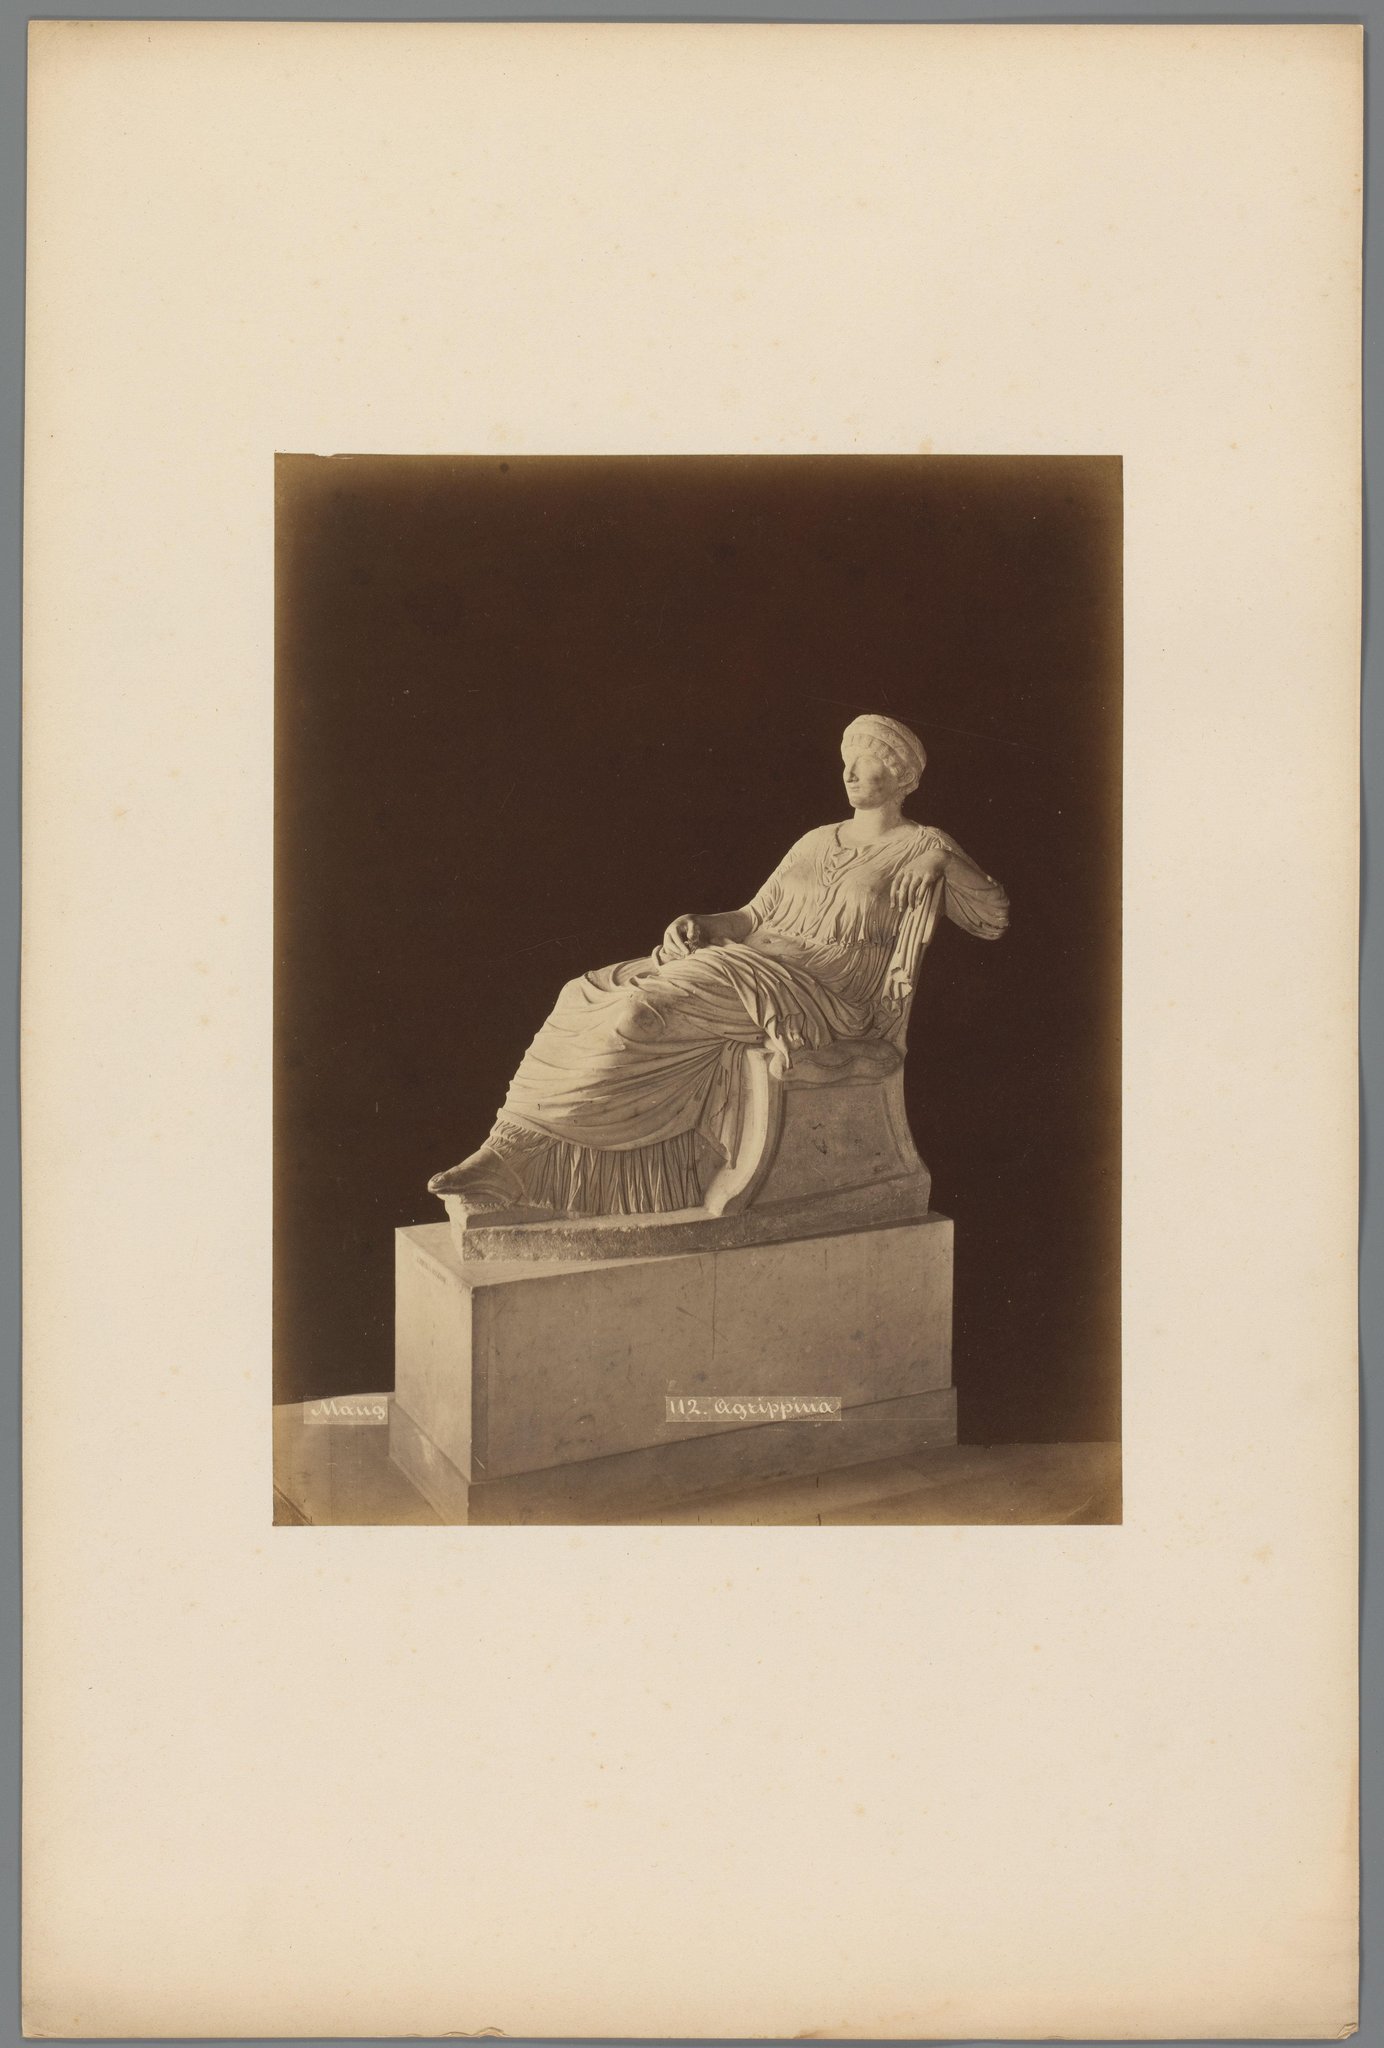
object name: photograph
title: Sculptuur van een zittende Agrippina de oudere in de Capitolijnse Musea te Rome, Italië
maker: michèle mang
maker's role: fotograaf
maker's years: 1840-1909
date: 1863-1887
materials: cardboard, paper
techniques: albumen print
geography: rome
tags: piece of sculpture, reproduction of a piece of sculpture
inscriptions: number: ‘112.’